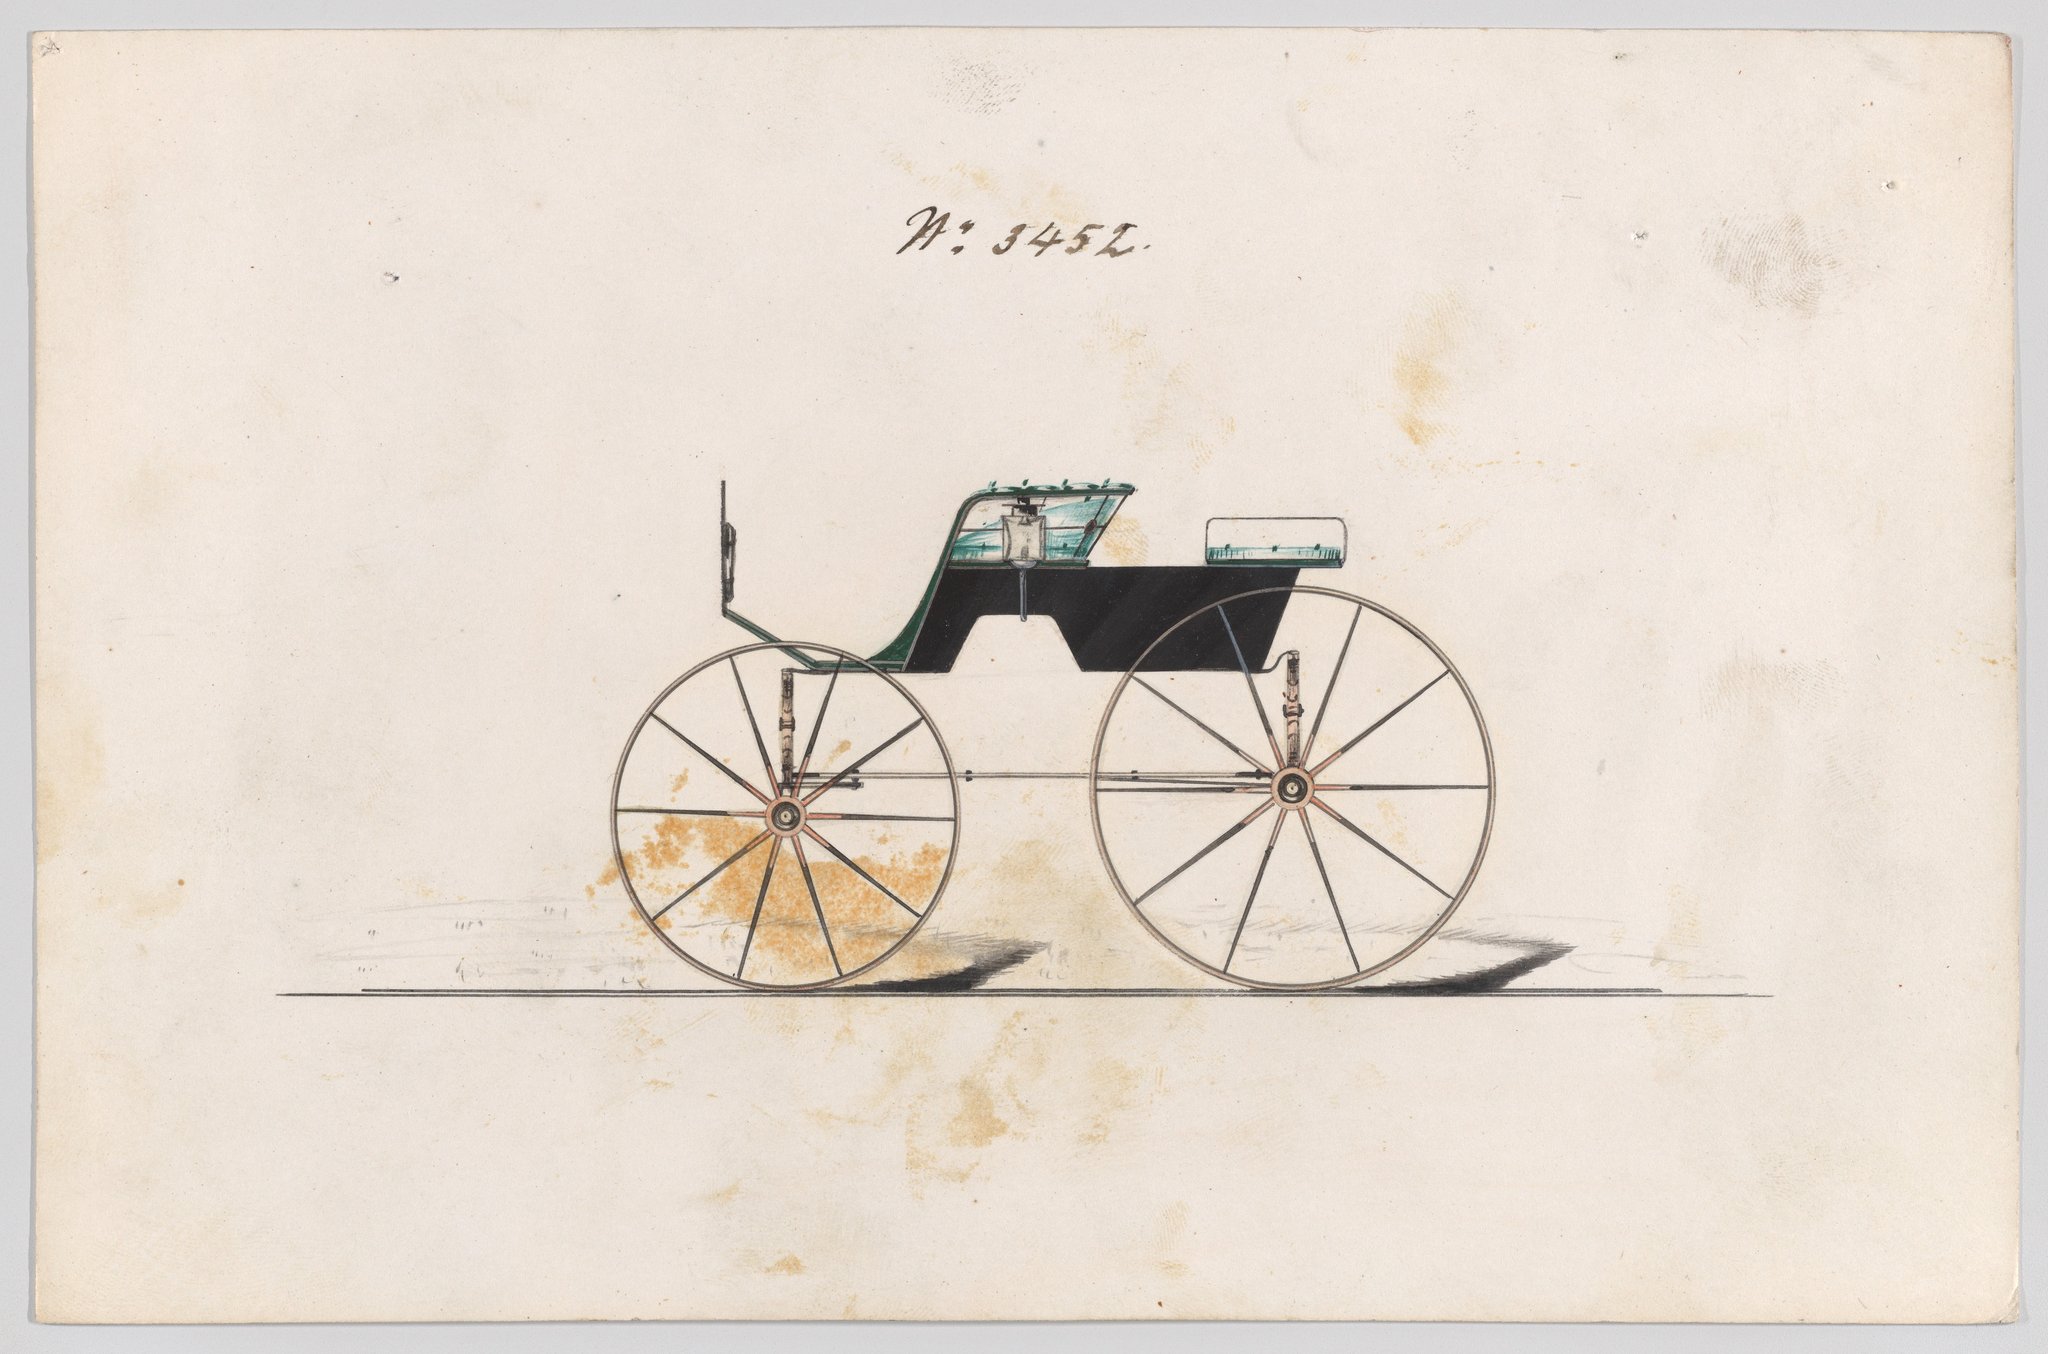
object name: drawing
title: Design for T-Cart, no. 3452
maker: brewster & co.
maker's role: manufacturer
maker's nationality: american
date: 1878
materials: gouache, gum arabic, ink, watercolor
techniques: pen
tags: carriages